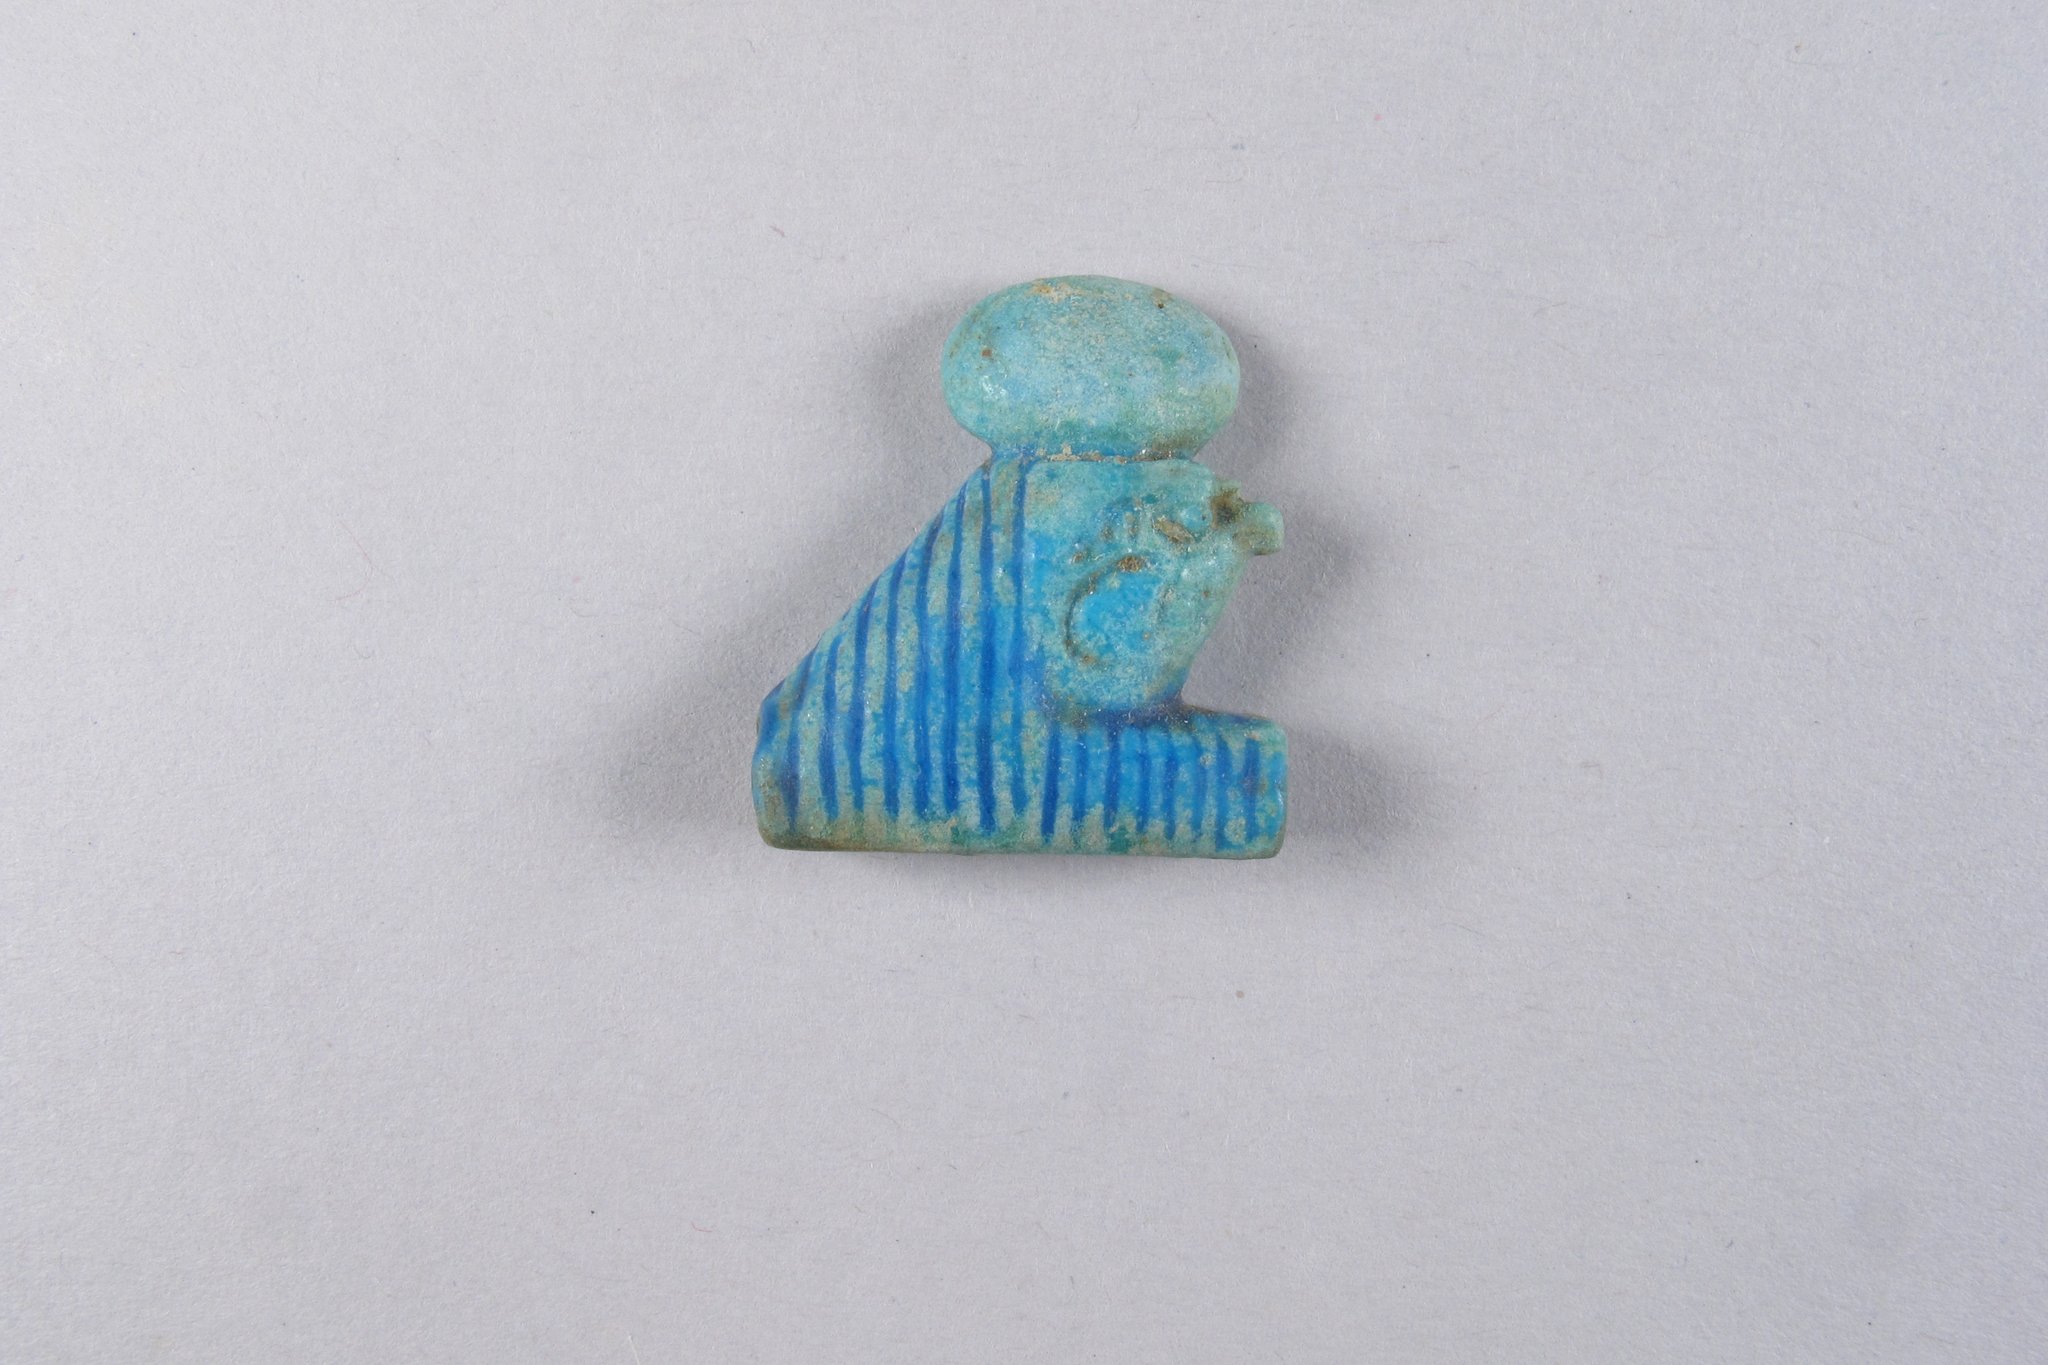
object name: collar terminal, falcon head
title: Collar terminal decorated with head of a falcon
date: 664-332 BCE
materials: faience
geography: egypt